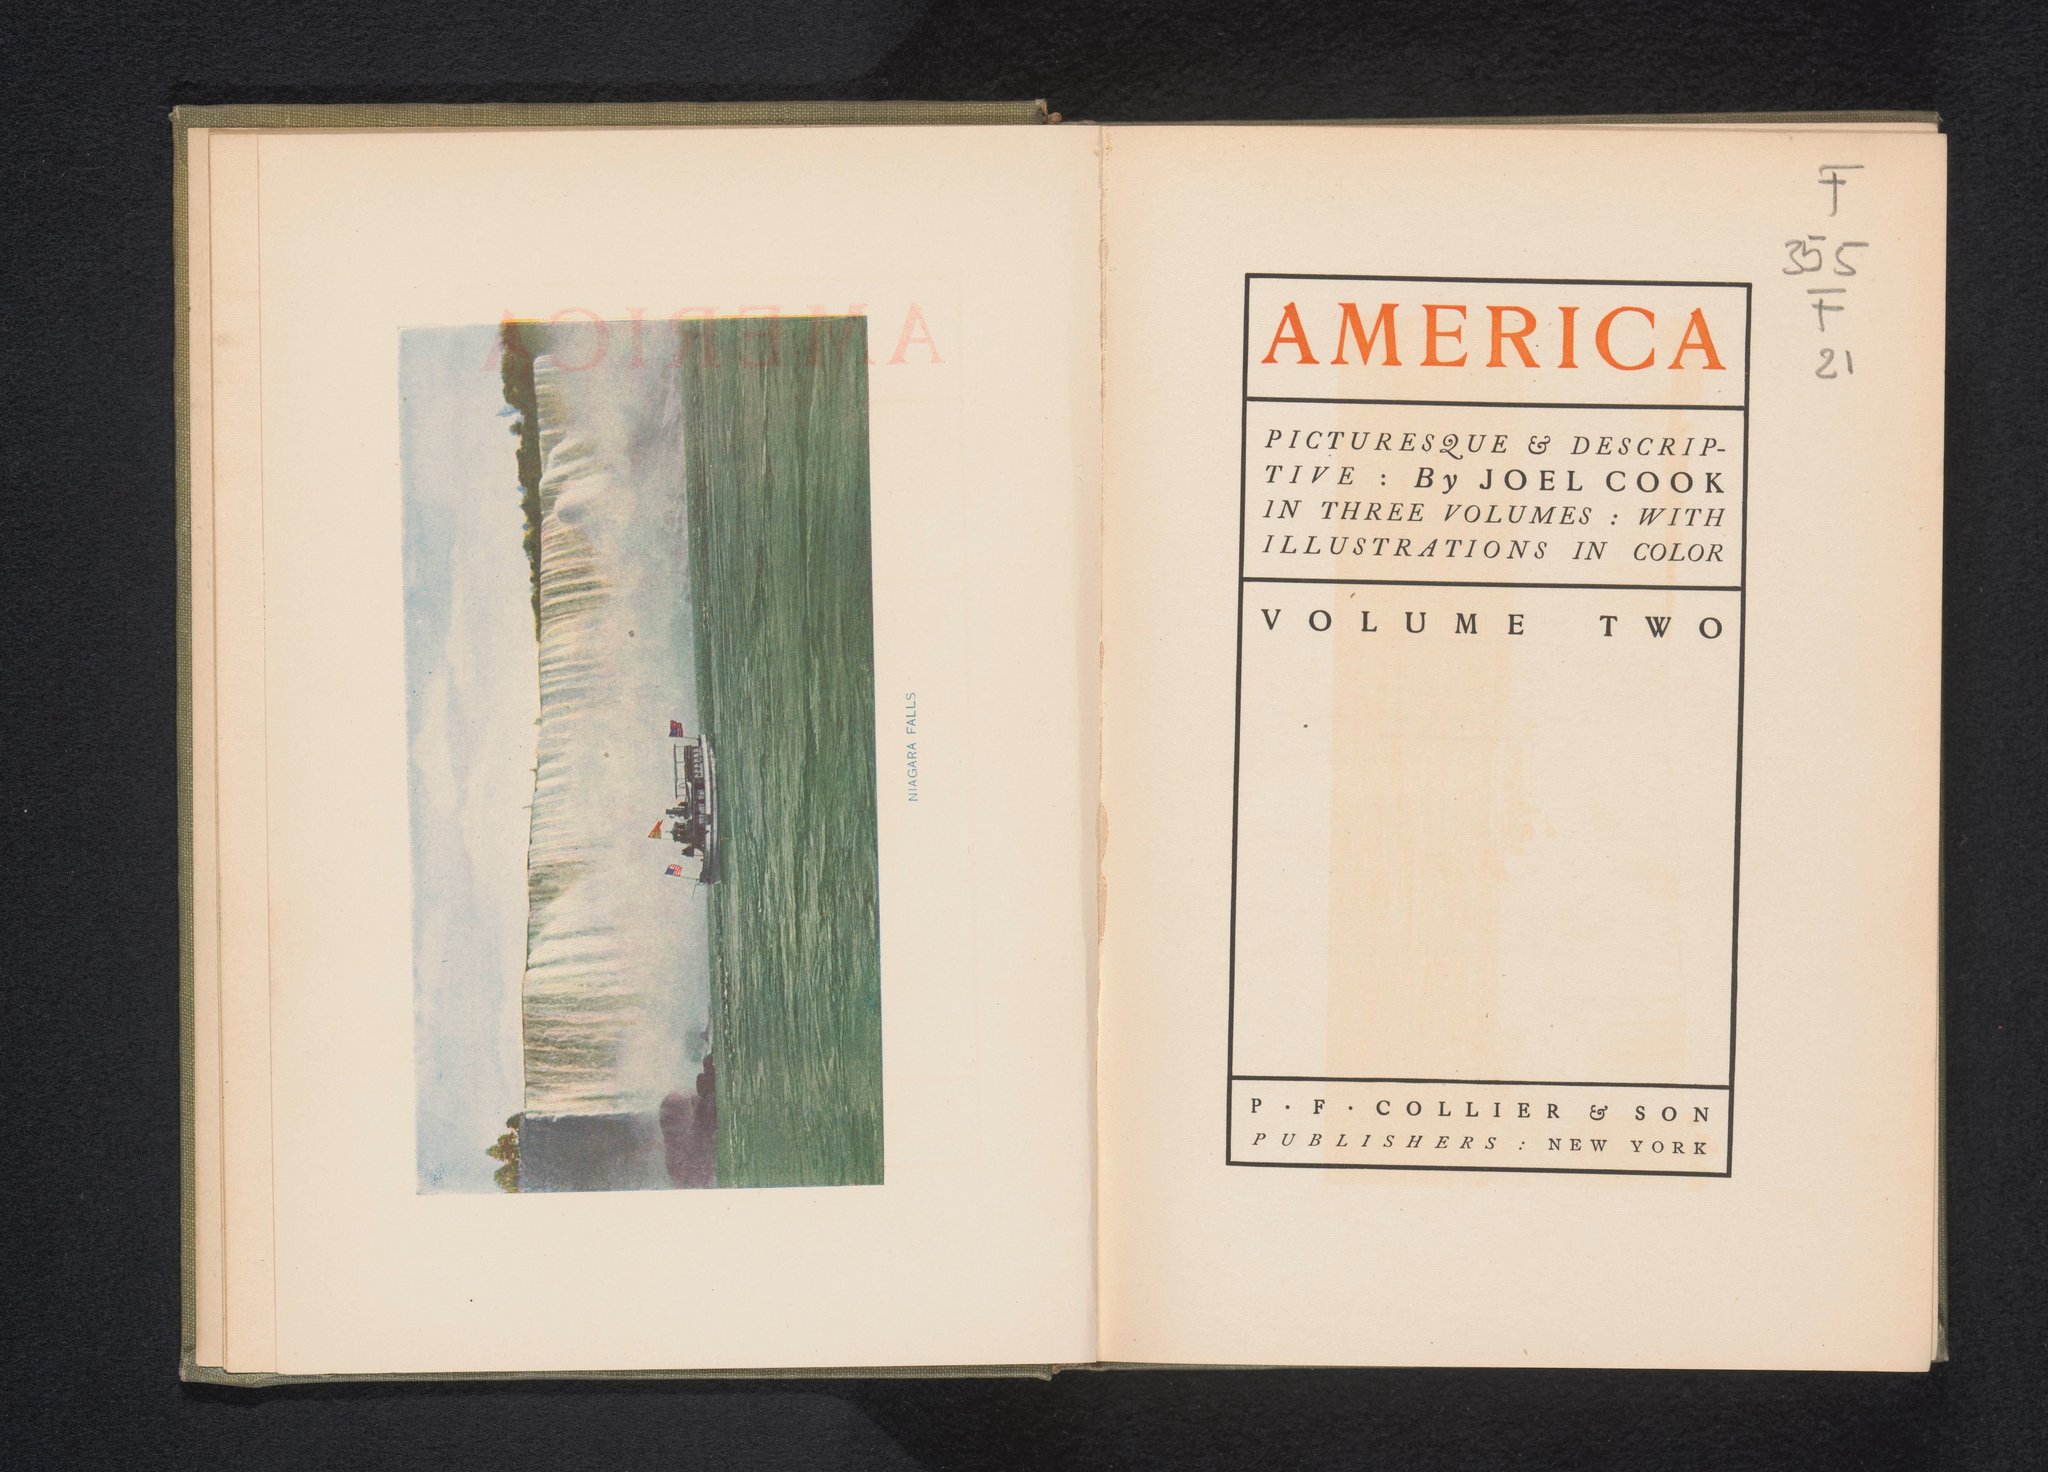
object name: photomechanical print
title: Niagara Falls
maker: Anonymous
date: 1890-1900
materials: paper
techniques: color autotype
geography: niagara falls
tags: waterfall